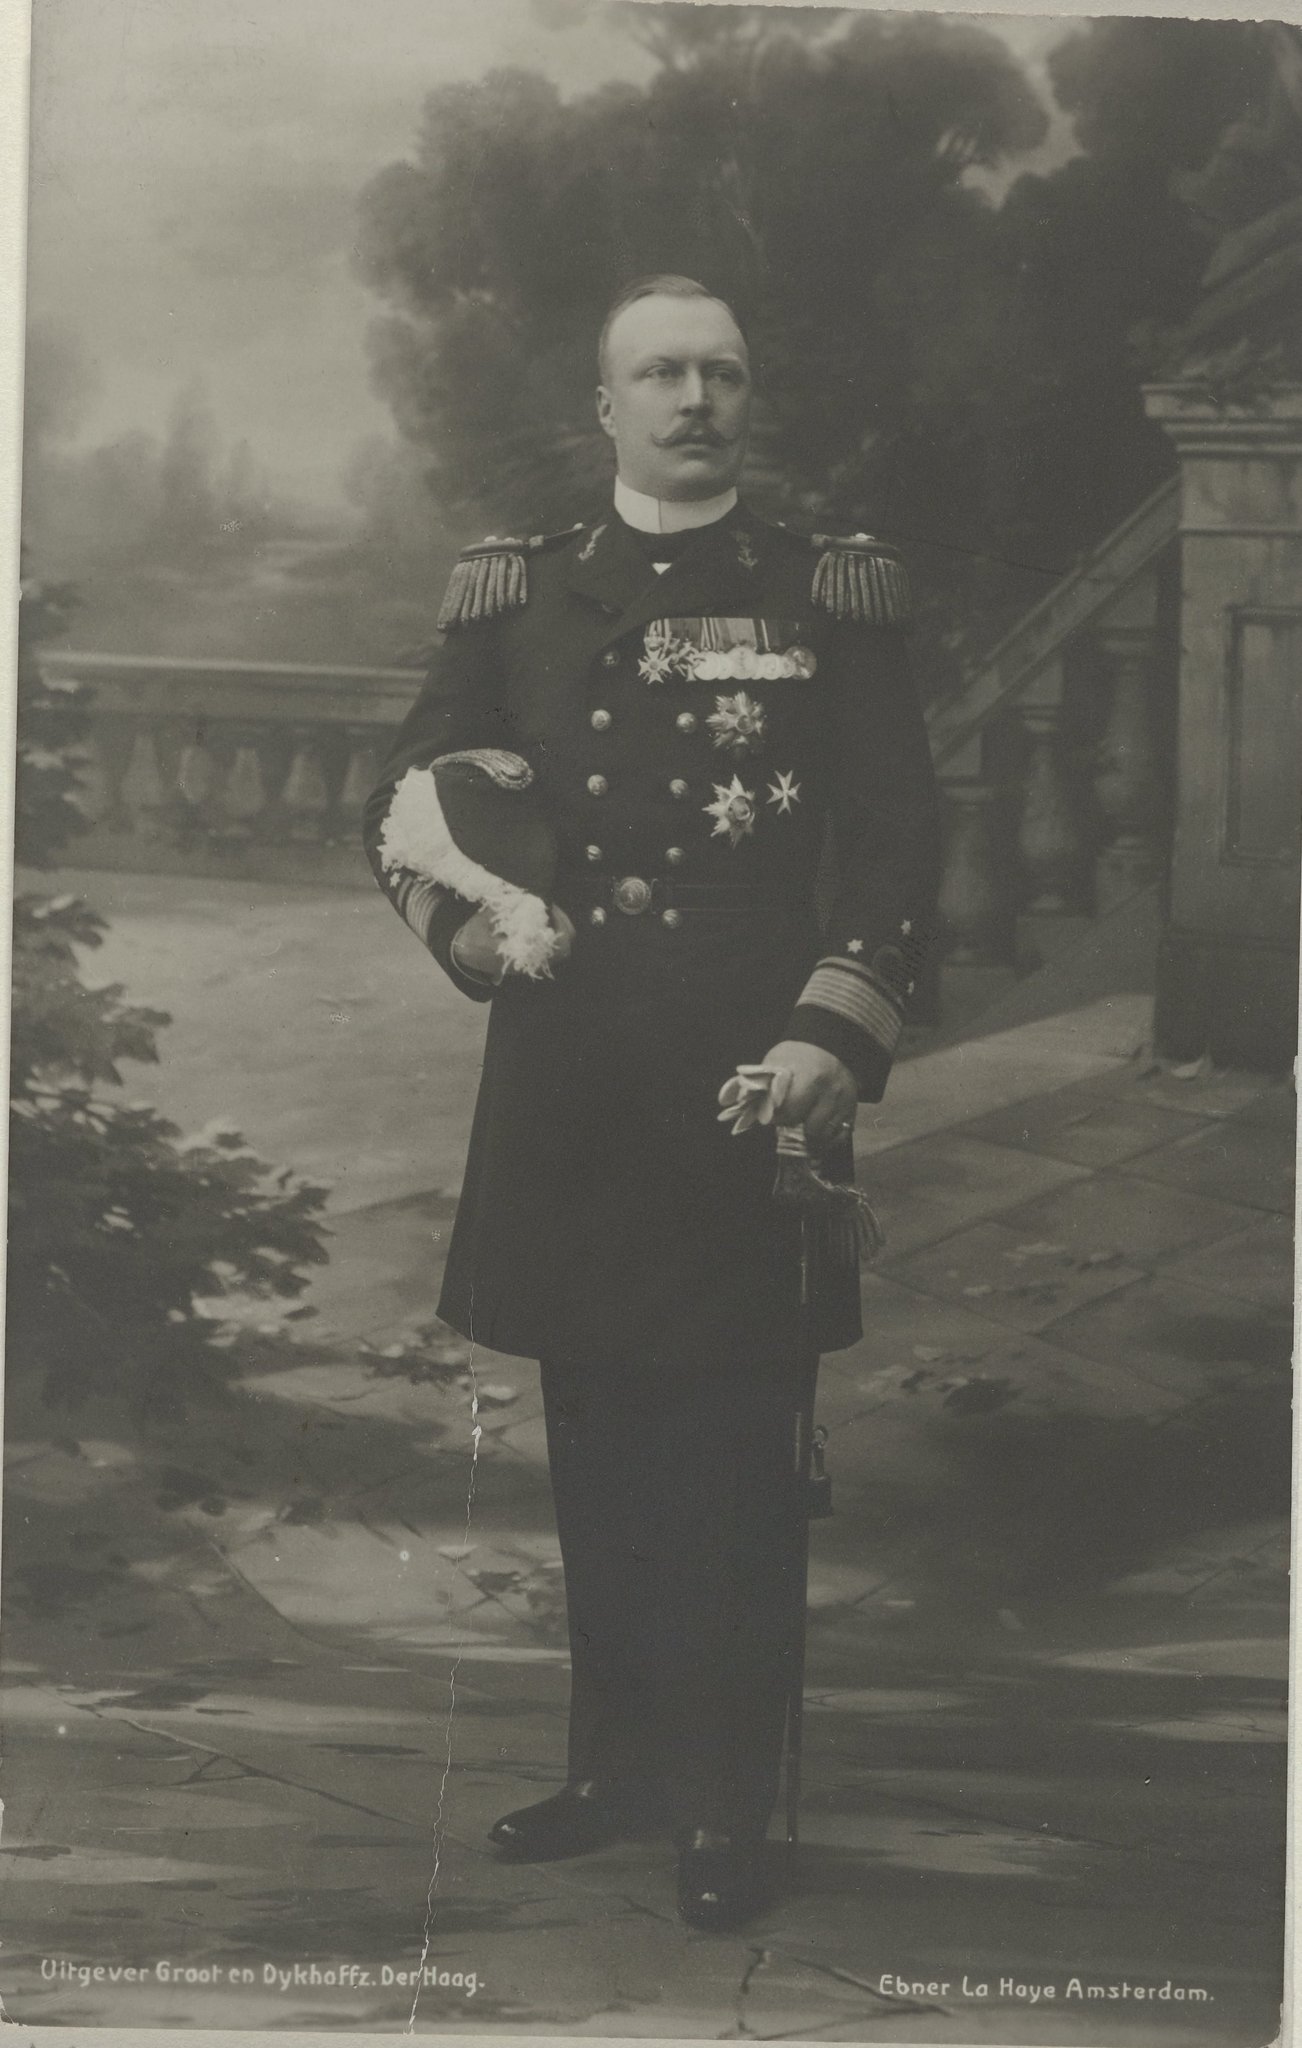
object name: ansichtkaart, prentbriefkaart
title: Portret van Hendrik van Mecklenburg-Schwerin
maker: ferdinand robert ebner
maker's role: fotograaf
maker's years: 1873-1919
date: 1900-1919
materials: photographic support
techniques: photography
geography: amsterdam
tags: the hague, hendrik (prins der nederlanden (1876-1934))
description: Portret van Hendrik. In zijn linkerhand zijn handschoenen. Op de achtergrond balustrades.